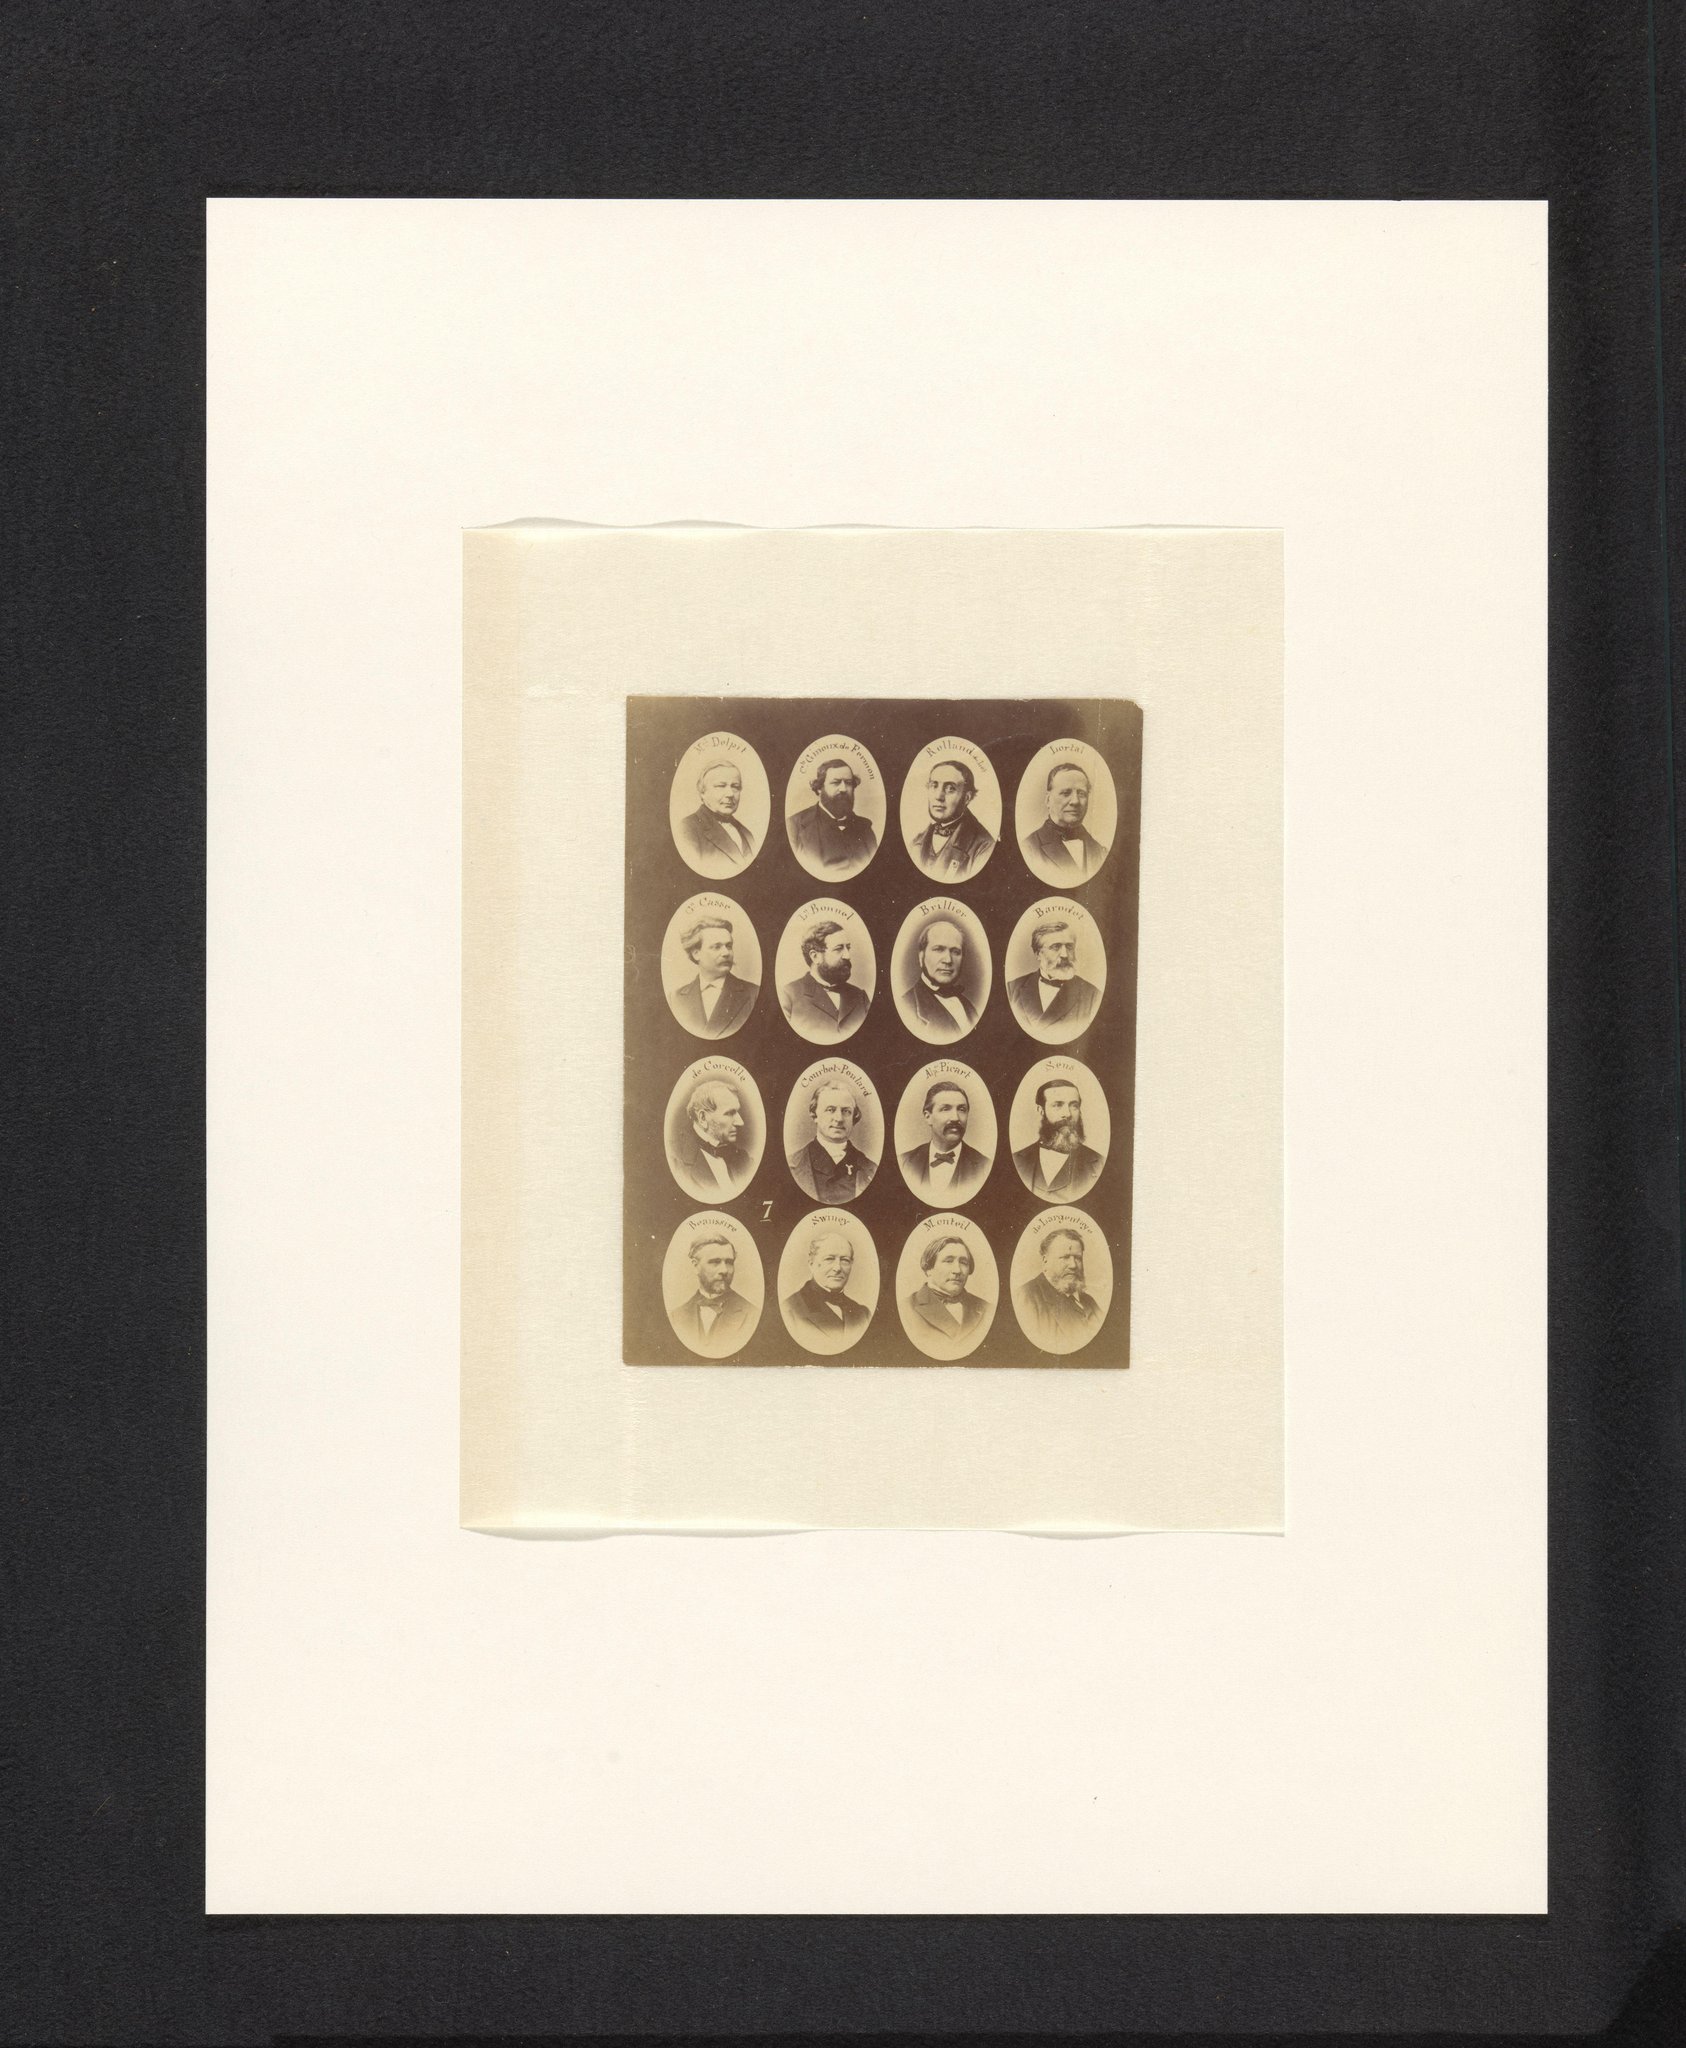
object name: montagefoto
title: Samengesteld groepsportret, vermoedelijk van leden van de Assembée Nationale van 1873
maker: françois marie louis franck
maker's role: fotograaf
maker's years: 1816-1906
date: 1868-1873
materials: photographic support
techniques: albumen print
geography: france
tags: politician, e.g. party leader, lower house, parliament, chamber, anonymous historical persons portrayed in a group, in a group-portrait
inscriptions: number: ‘7’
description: Foto op los opzetvel in een envelop achterin het boek.